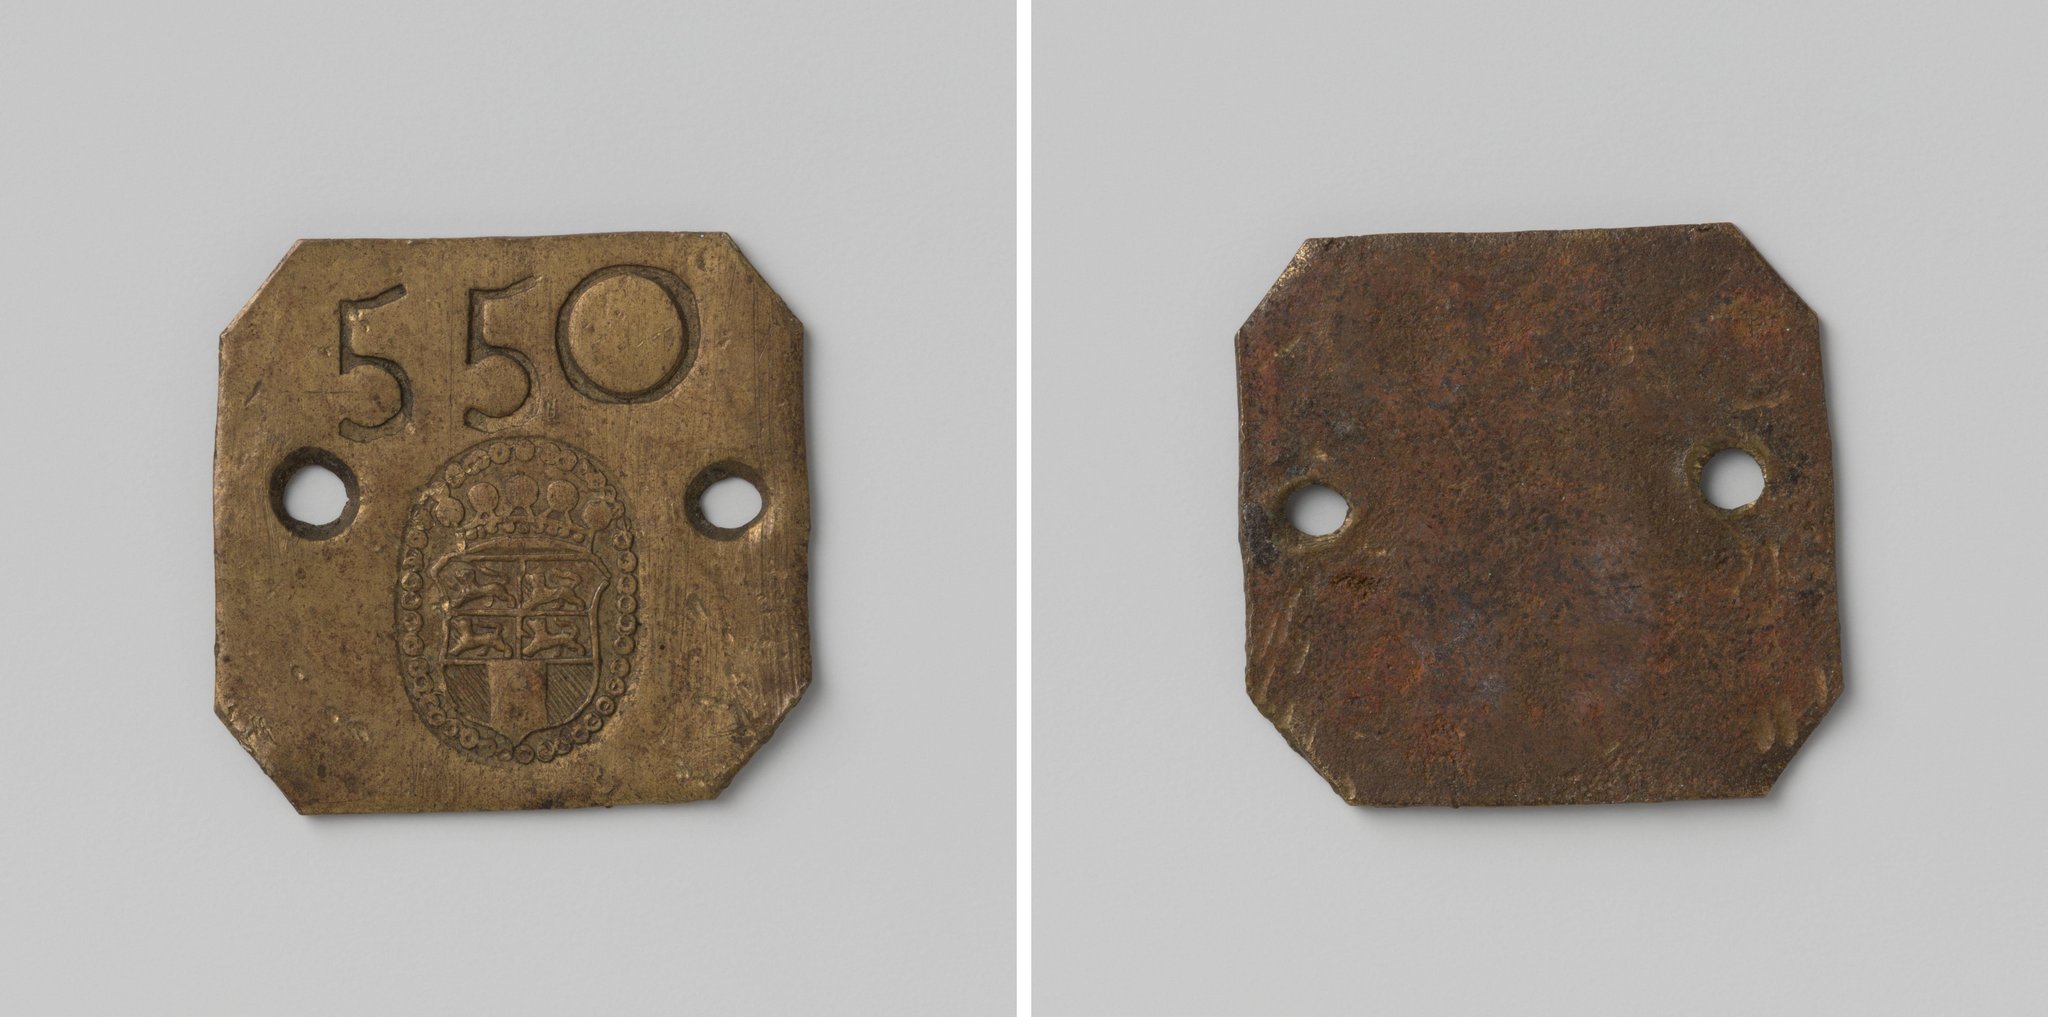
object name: tax token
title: Stad Rotterdam, loodje met no. 550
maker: Anonymous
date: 1800-1875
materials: brass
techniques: striking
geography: rotterdam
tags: rotterdam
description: eenzijdig, vierkant loodje met afgeschuinde hoeken en links en rechts een gat. Voorzijde: wapenschild binnen parelrand onder cijfer 550; op onderste deel van wapenschild: letter S. Keerzijde: blanco